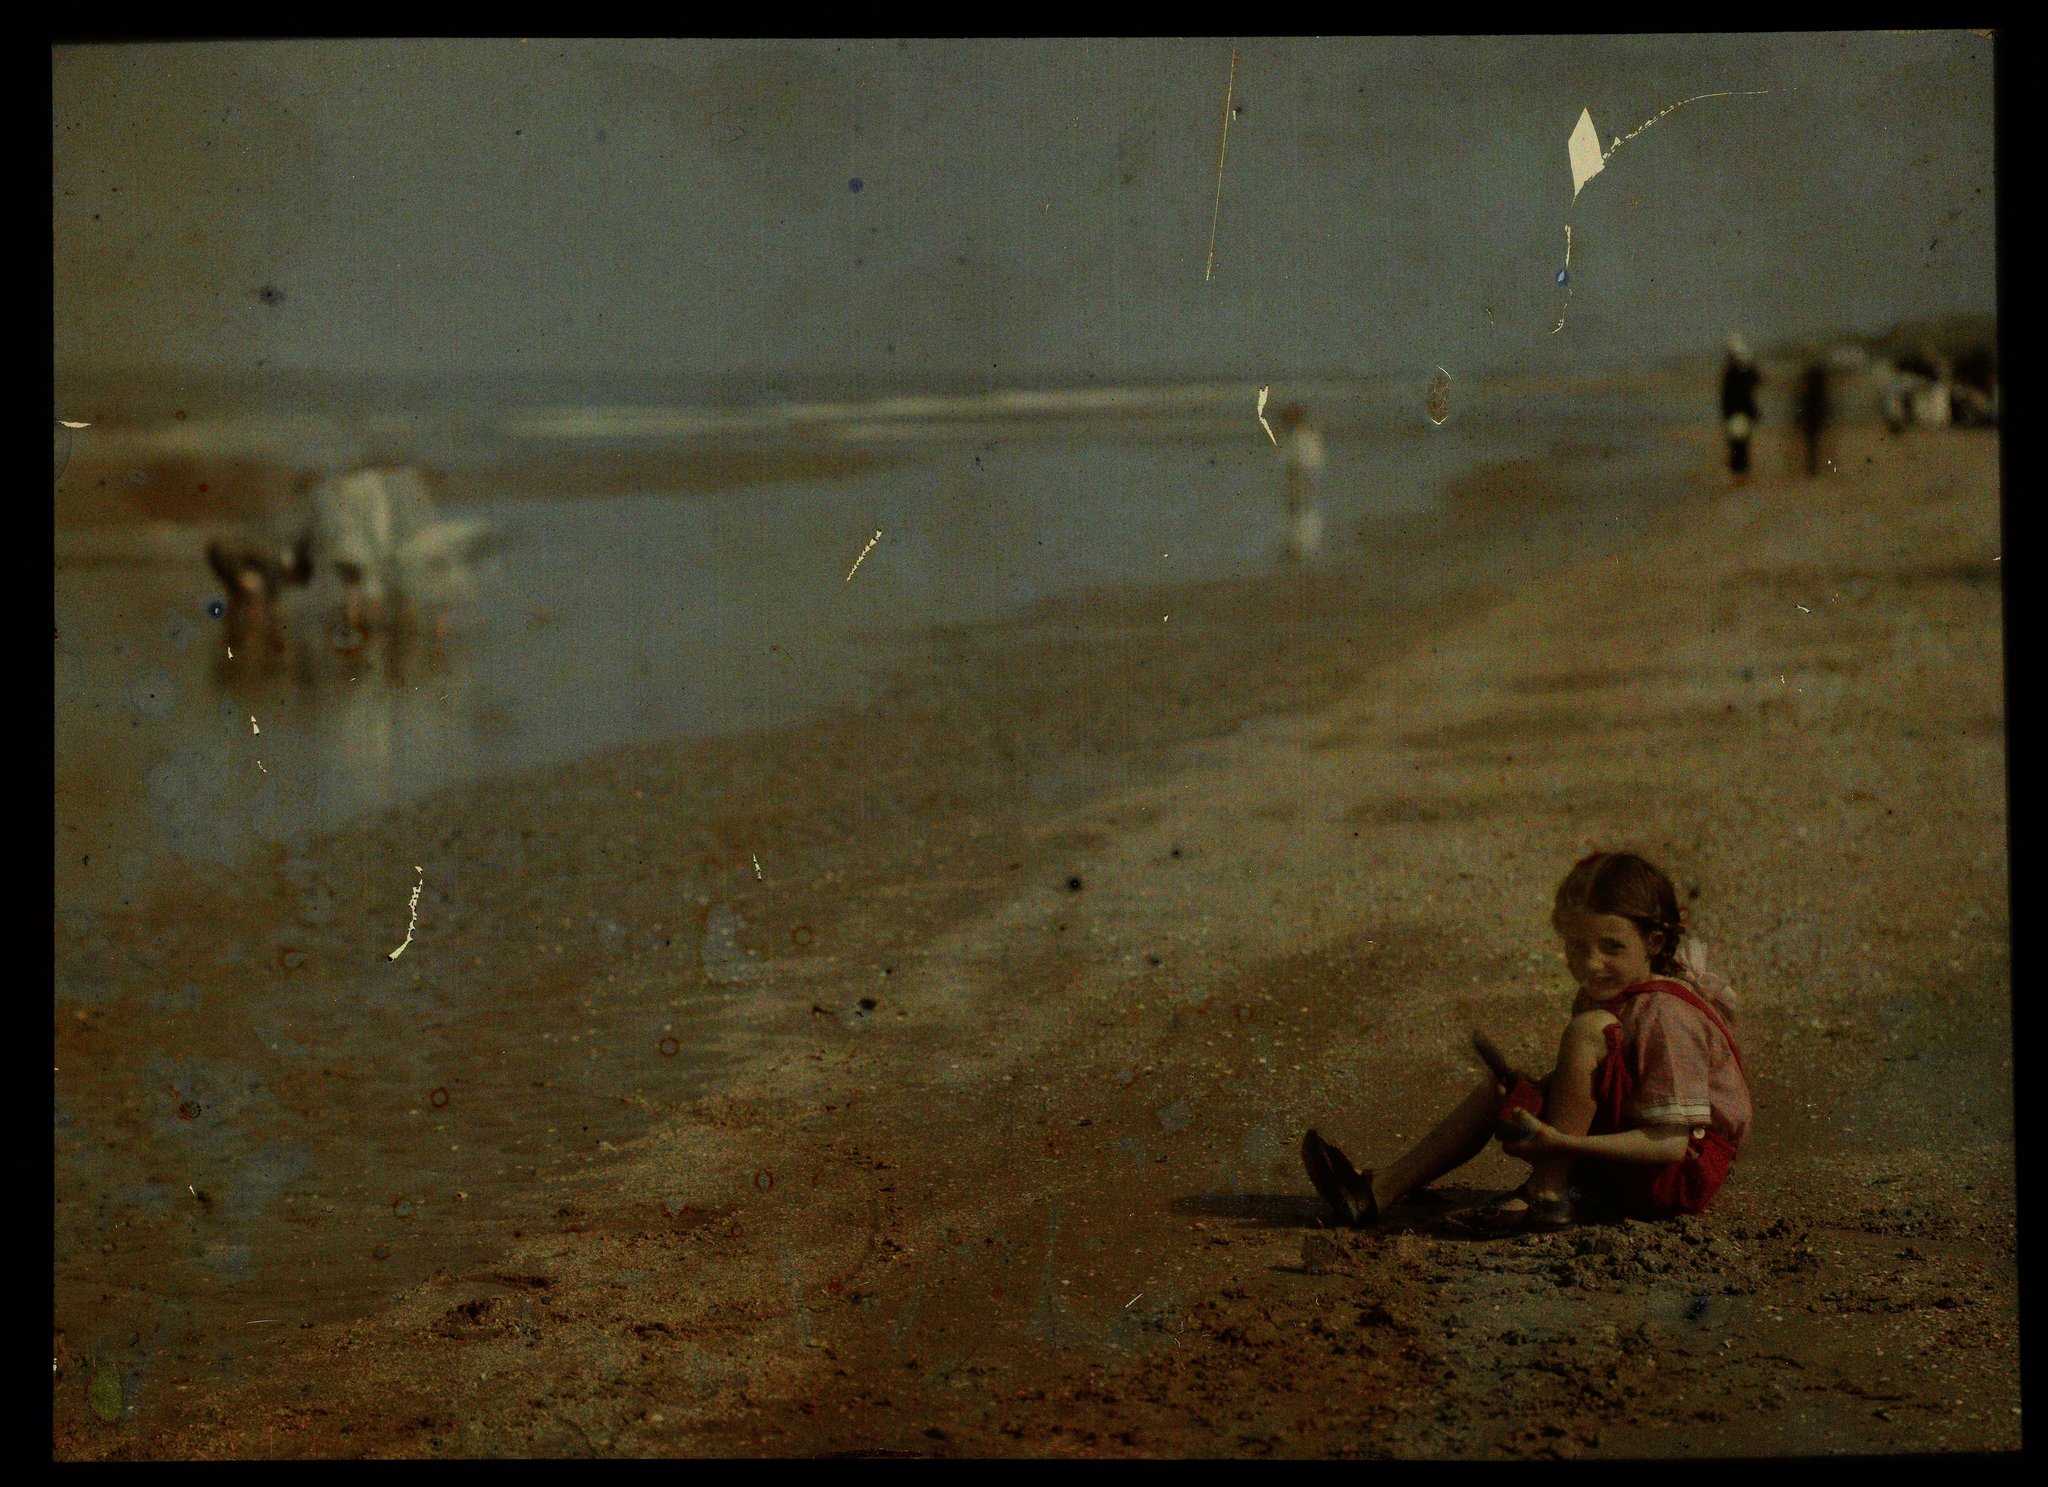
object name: color slide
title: Meisje (gekleed in het rood, zittend) spelend aan het Noordzeestrand, met allerlei figuren op de achtergrond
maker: adolphe burdet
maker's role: fotograaf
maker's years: 1860-1940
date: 1907-1930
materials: glass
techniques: autochrome process, slide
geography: netherlands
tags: noordzee